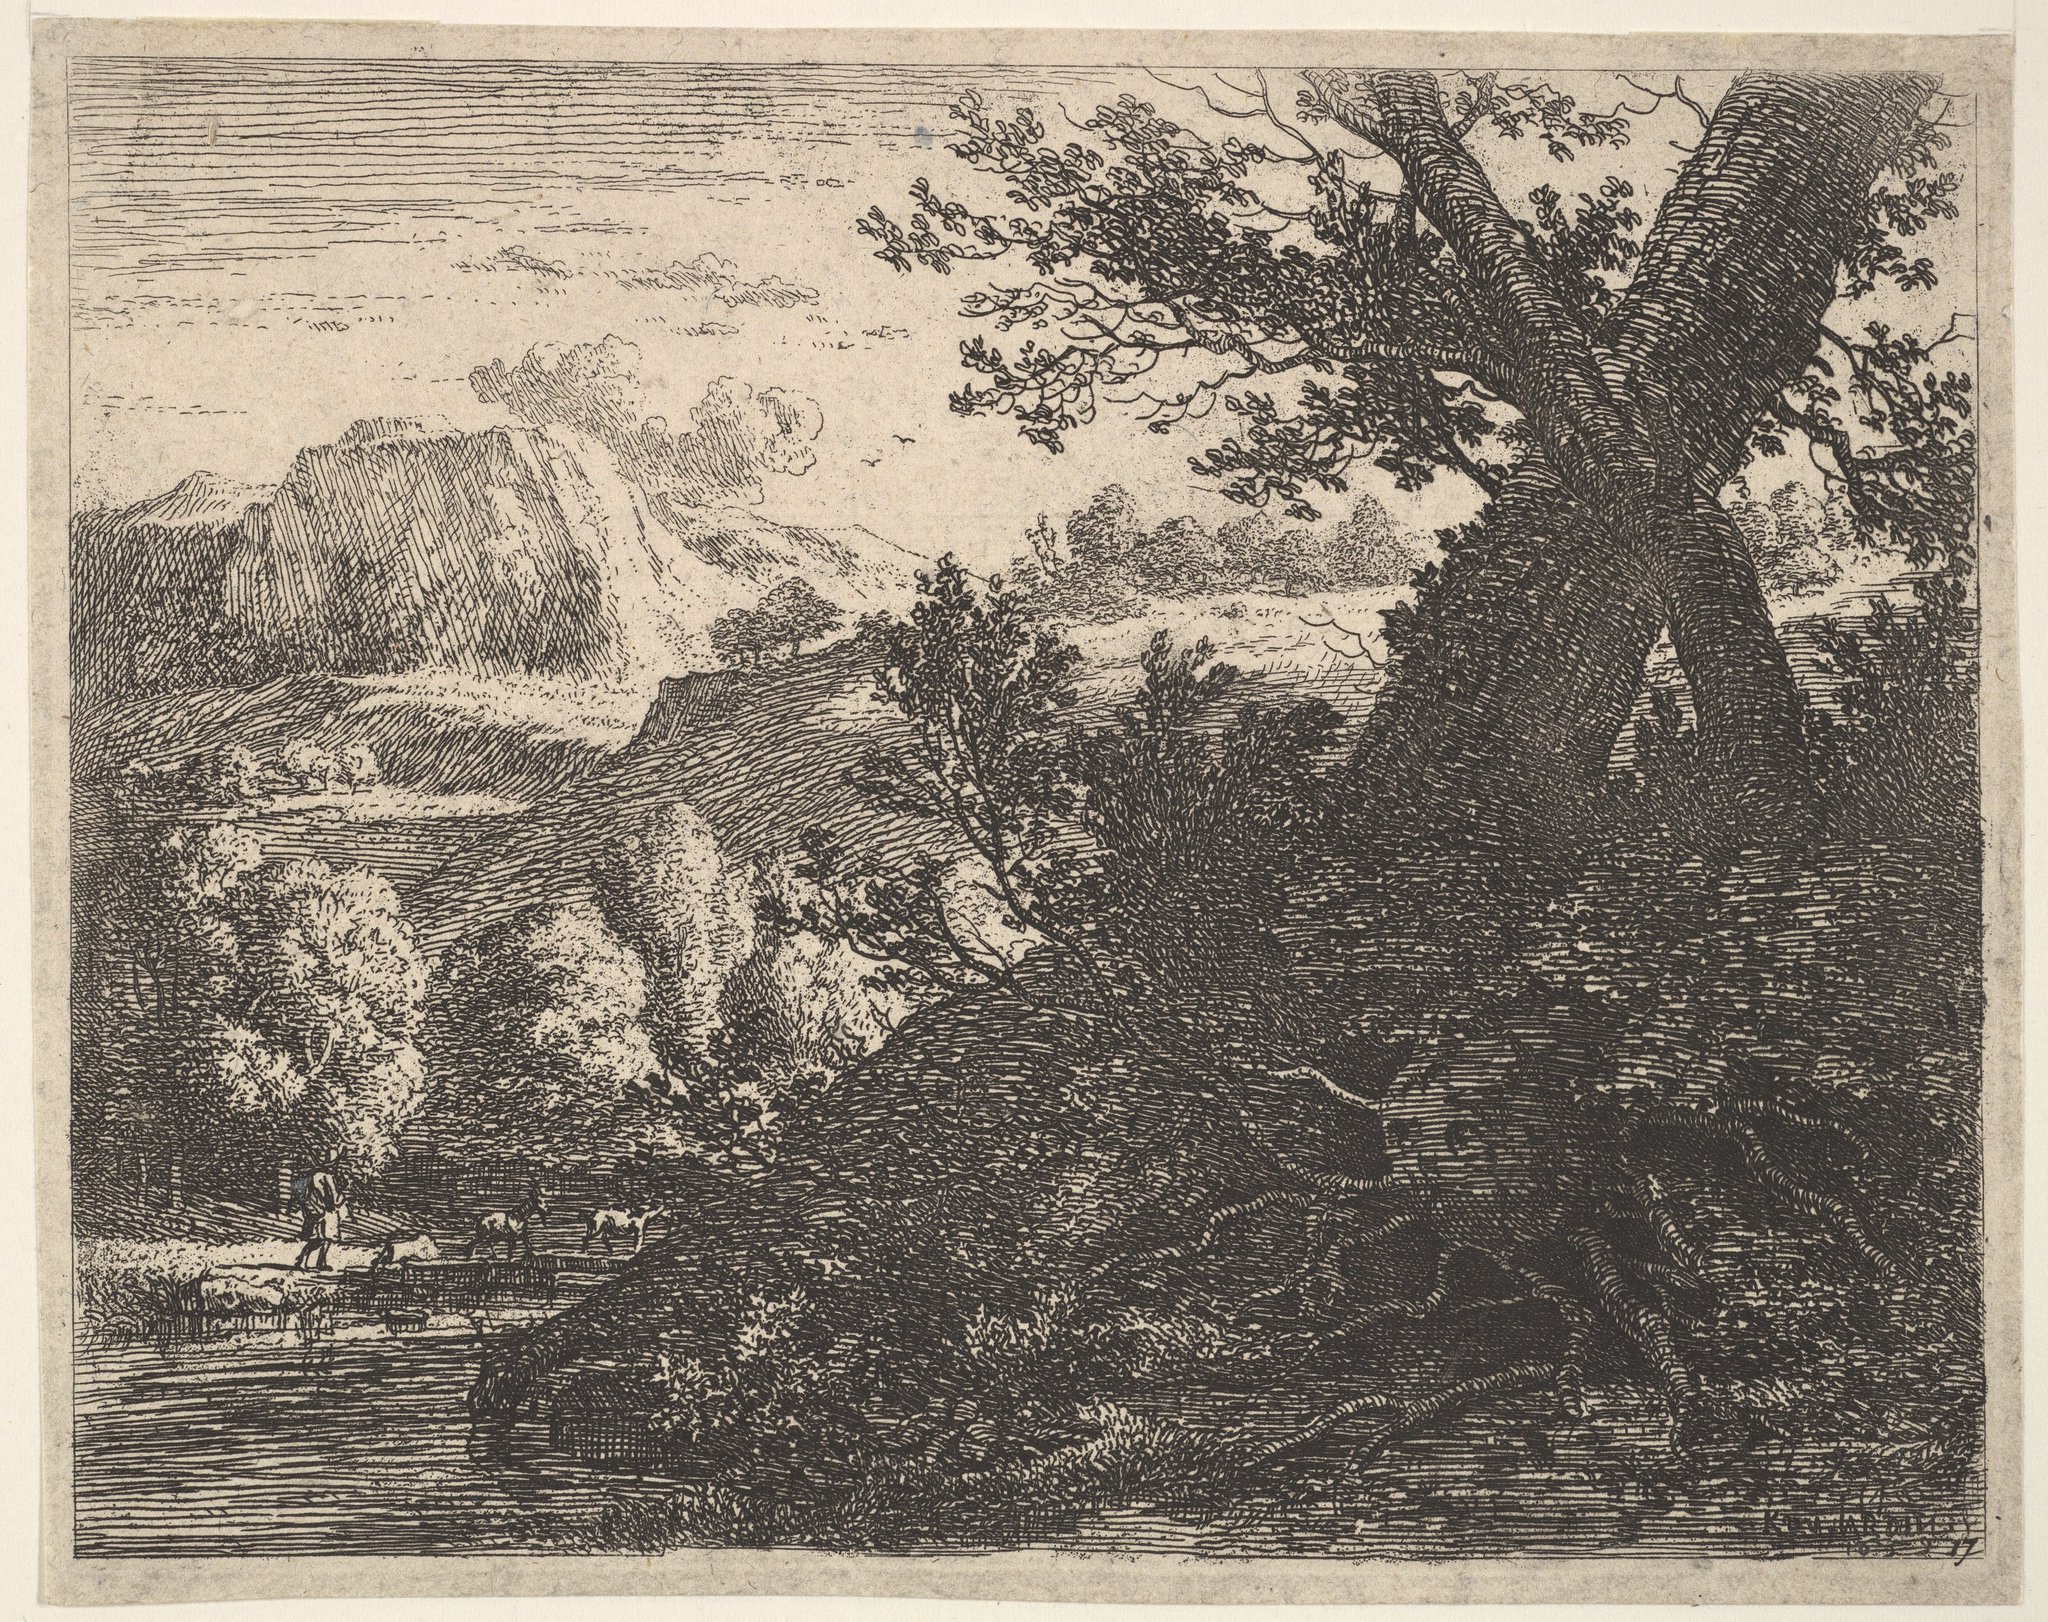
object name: print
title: Tree with roots laid bare alongside a stream, a hilly landscape and a man walking behind quadrupeds beyond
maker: karel dujardin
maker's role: artist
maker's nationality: dutch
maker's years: 1622-1678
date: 1659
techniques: etching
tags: animals,men,rivers,landscapes,trees